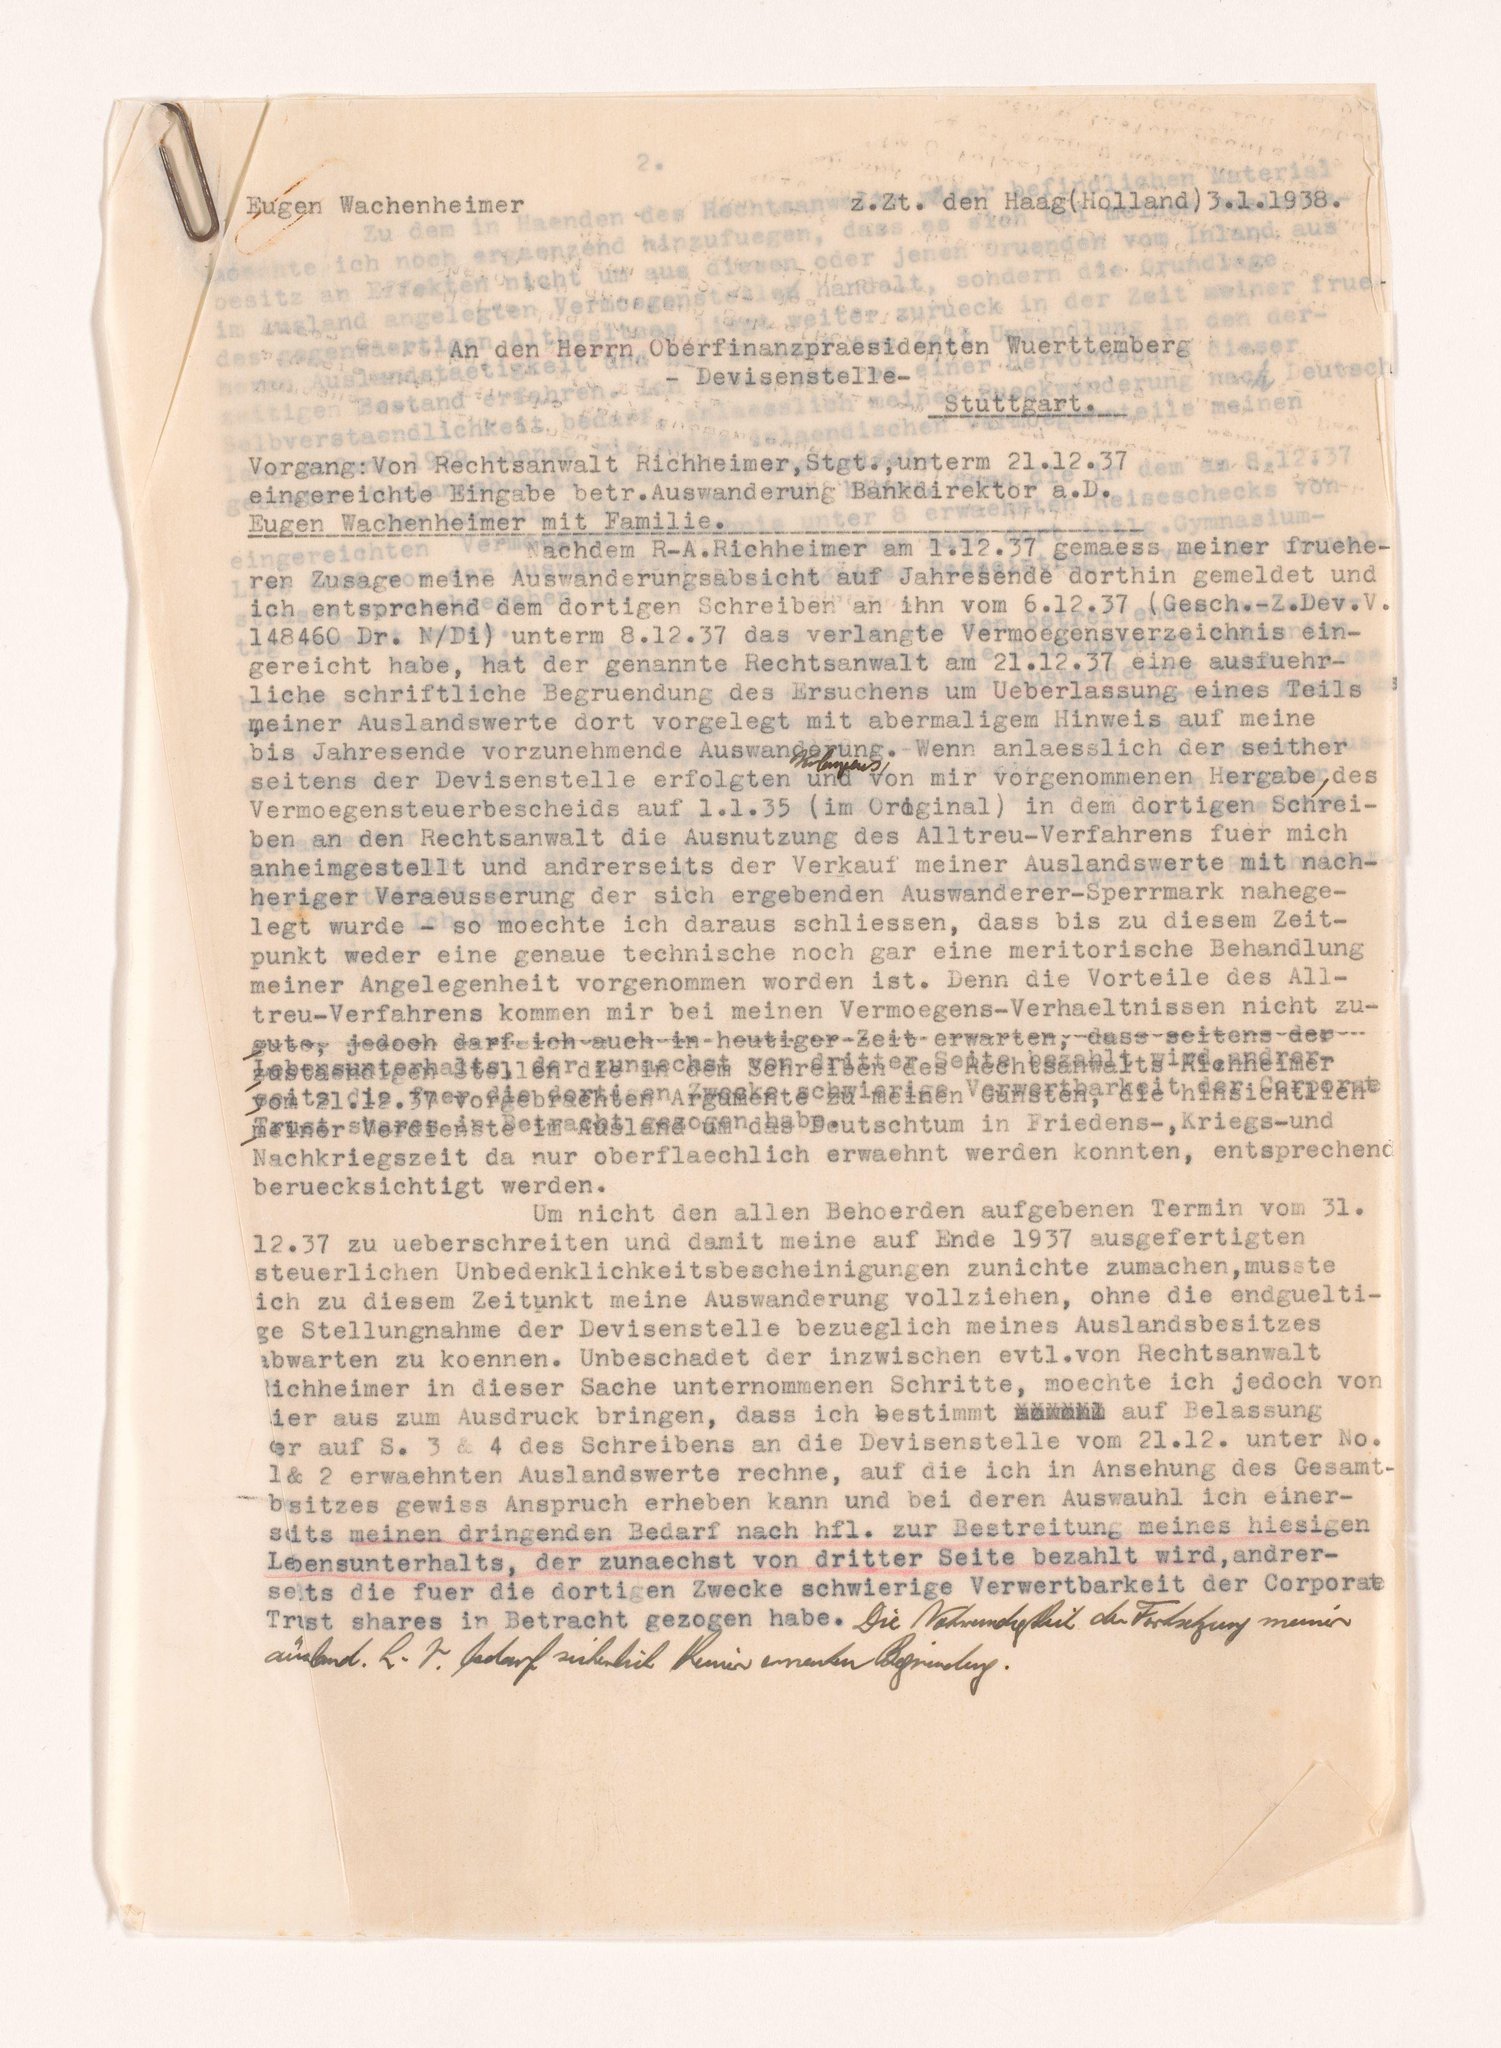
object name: document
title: Correspondentie Eugen Wachenheimer met Deutsche Bank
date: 1938-1942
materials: paper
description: Dit object is onderdeel van de nalatenschap van Isabel Elon-Wachenheimer (1928-2010). Tot haar overlijden behoorde het samen met de andere objecten uit de nalatenschap tot haar privédomein van Isabel Wachenheimer. In die particuliere context zijn deze objecten tezamen en individueel aandenkens - aan de jeugd, ouders en familie van Isabel Wachenheimer vóór en tijdens de Shoah en aan haar leven na de Tweede Wereldoorlog. Isabel Wachenheimer, die van juni 1943 tot mei 1945 gevangen zat in Kamp Westerbork, Theresienstadt, Auschwitz, Lenzing a/d Oberdonau (een buitenkamp van Mauthausen), overleefde de Shoah. Haar ouders – Eugène Wachenheimer en Else Wachenheimer-Moos - werden op 14 oktober 1944 in Auschwitz-Birkenau vermoord.